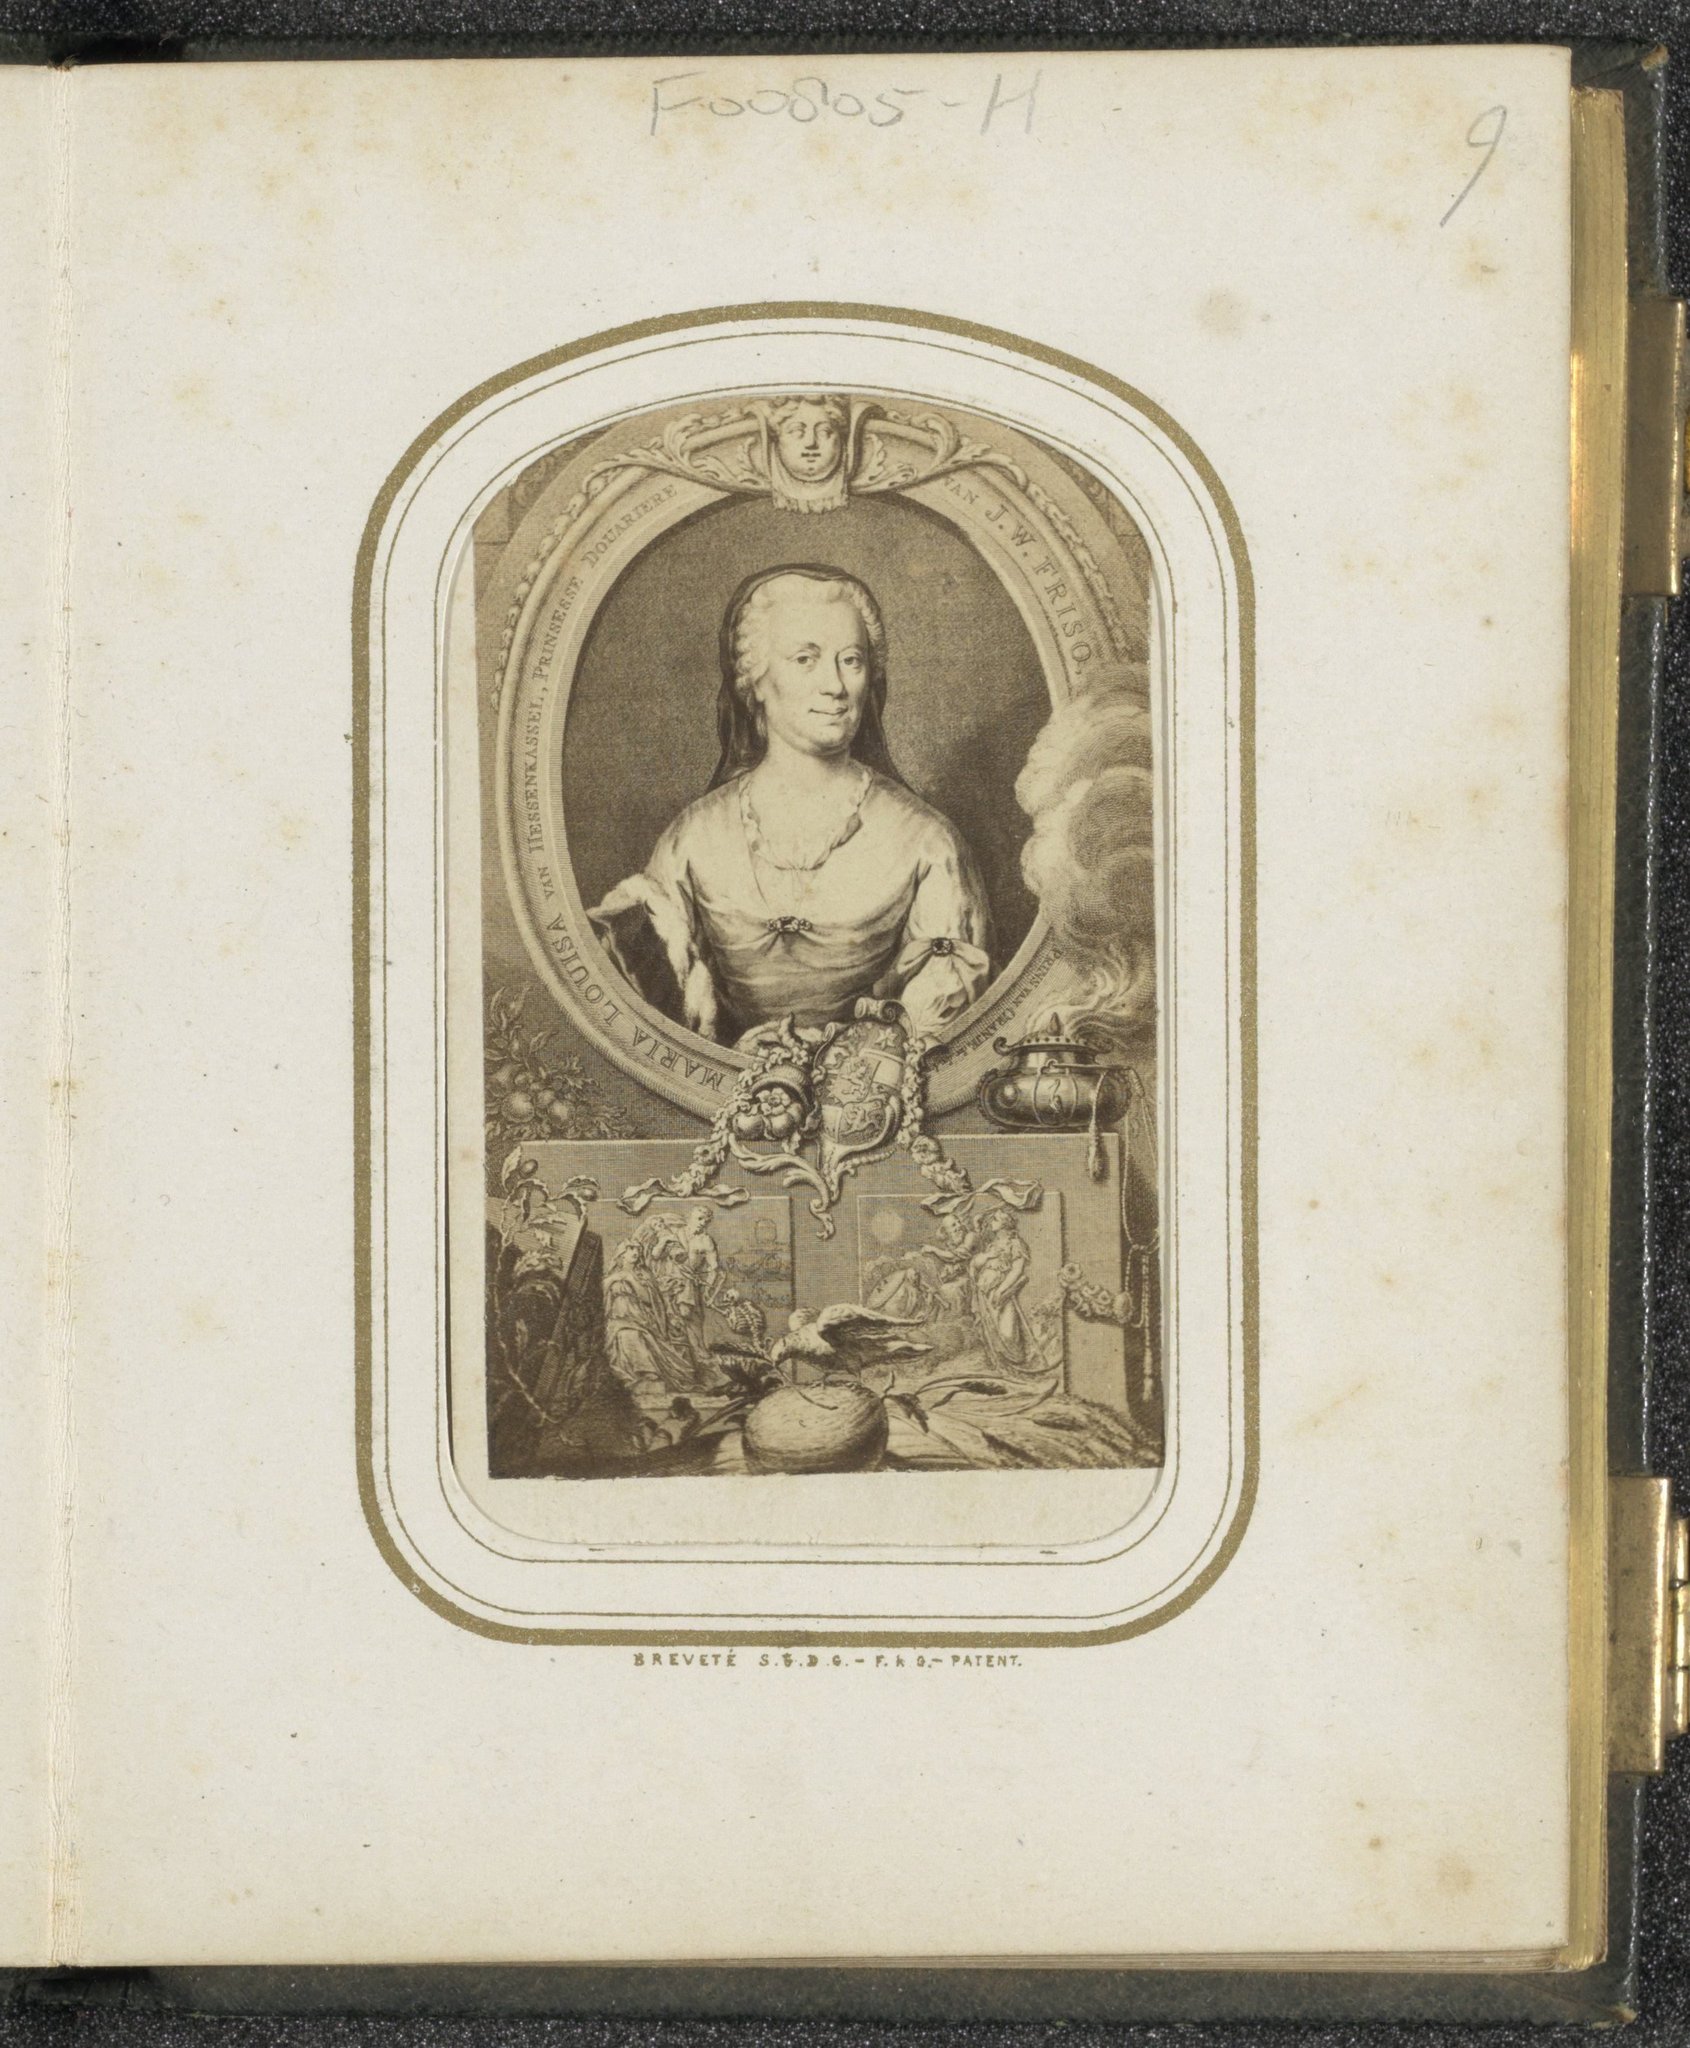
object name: reproduction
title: Fotoreproductie van (vermoedelijk) een prent van prinses Maria Louisa van Hessen-Kassel, echtgenote van Johan Willem Friso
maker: Anonymous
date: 1860-1880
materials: cardboard, paper, photographic support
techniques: albumen print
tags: head-gear, historical persons, brooch, agraffe, clasp, princess, dress, gown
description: Onderdeel van Fotoalbum met 29 foto's van Nederlandse vorsten.